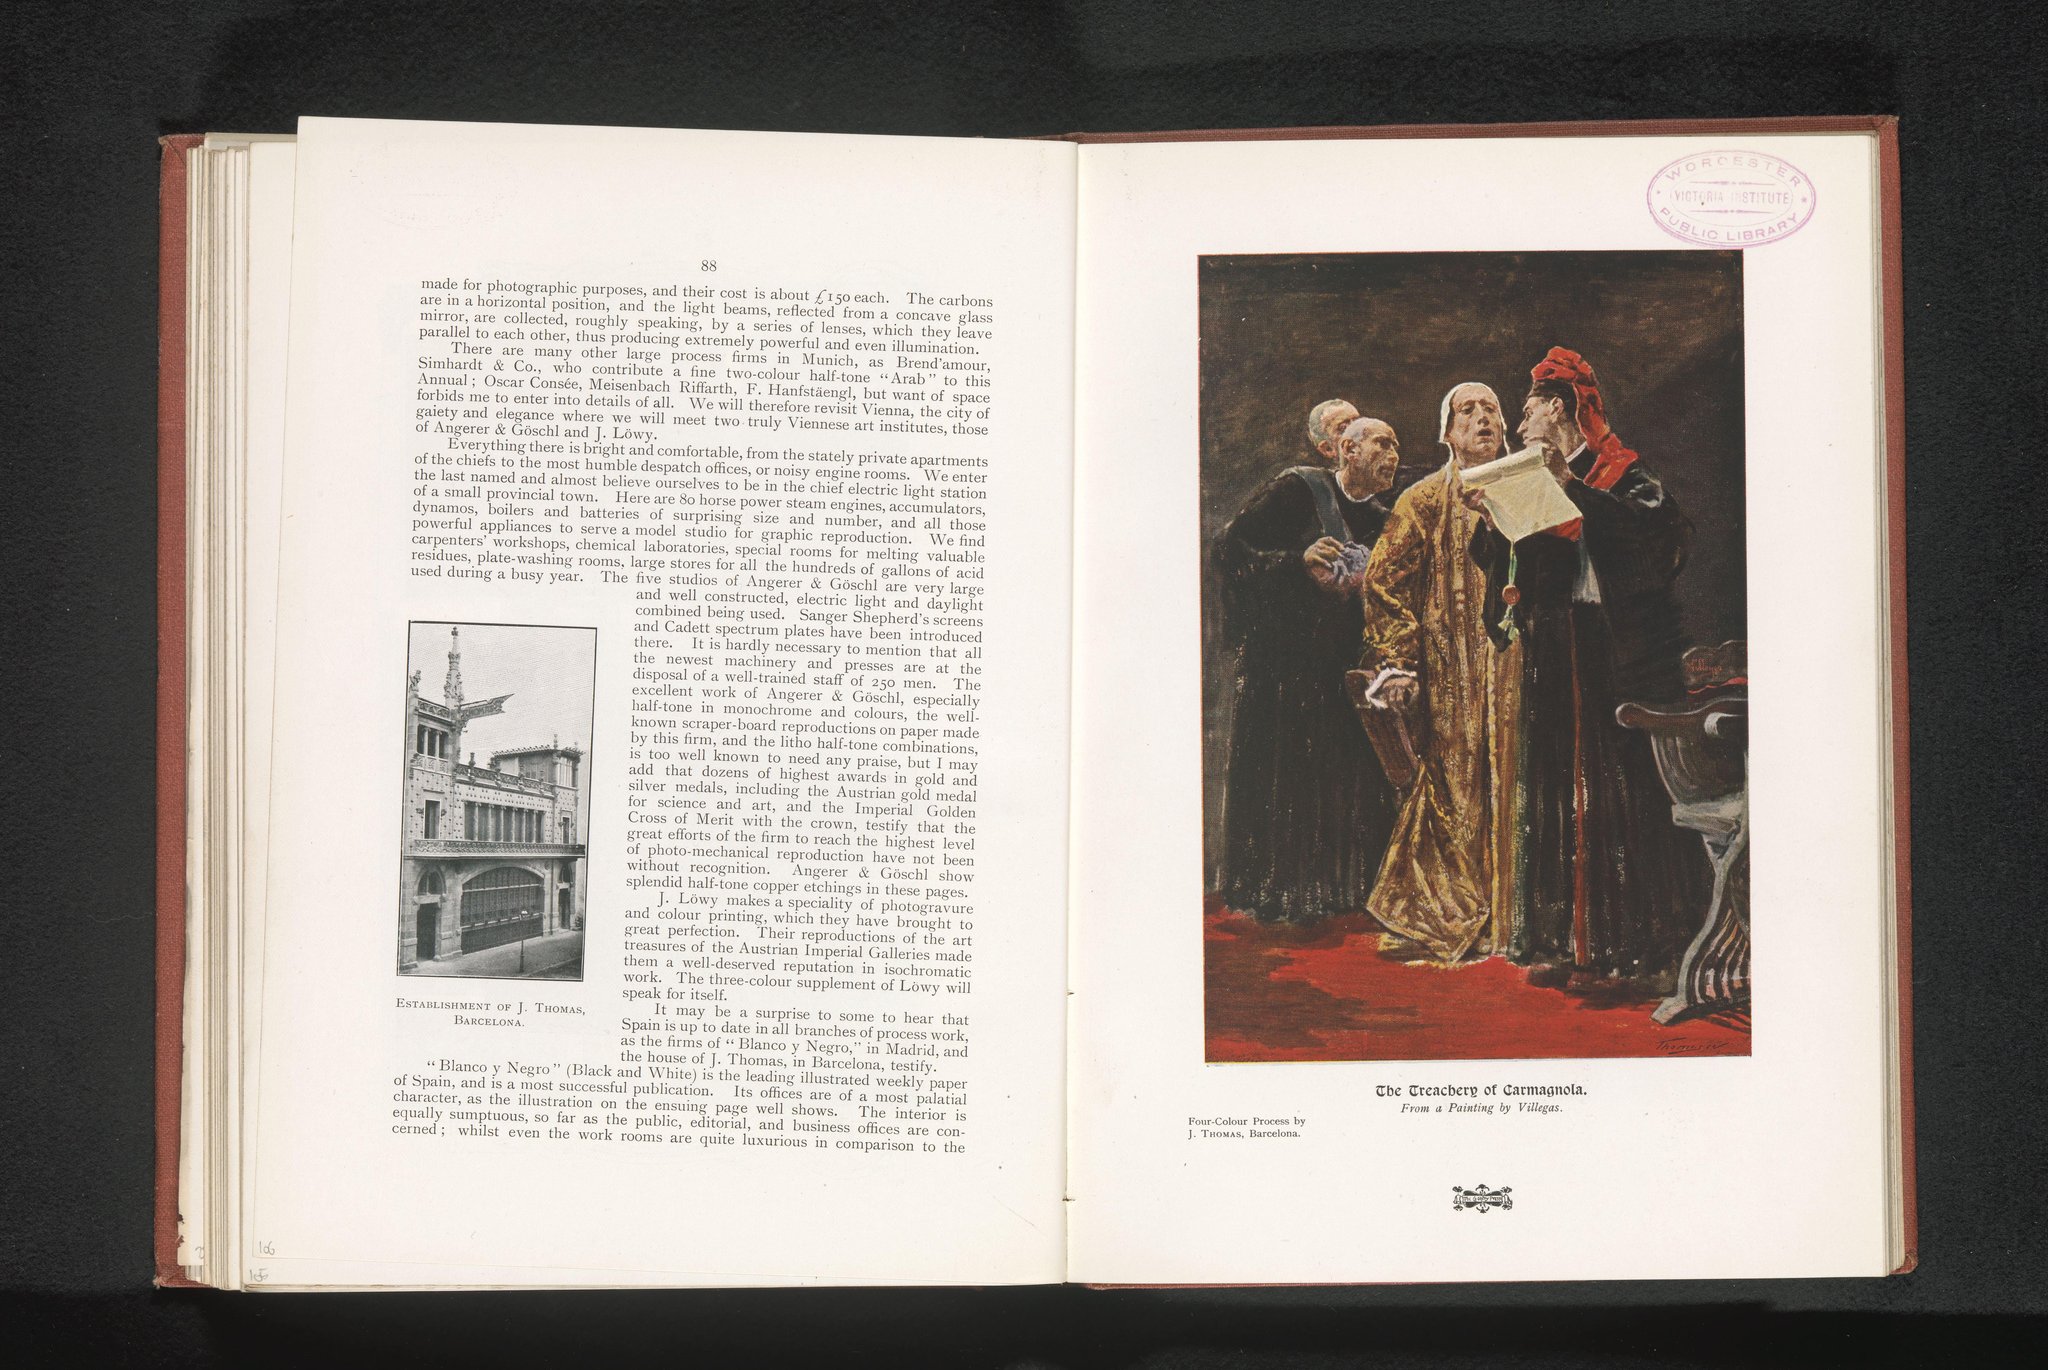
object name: reproduction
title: The treachery of Carmagnola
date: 1895-1900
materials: paper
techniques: autotype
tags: old man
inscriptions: collector's mark: ‘Worcester Public Library/ Victoria Institute’